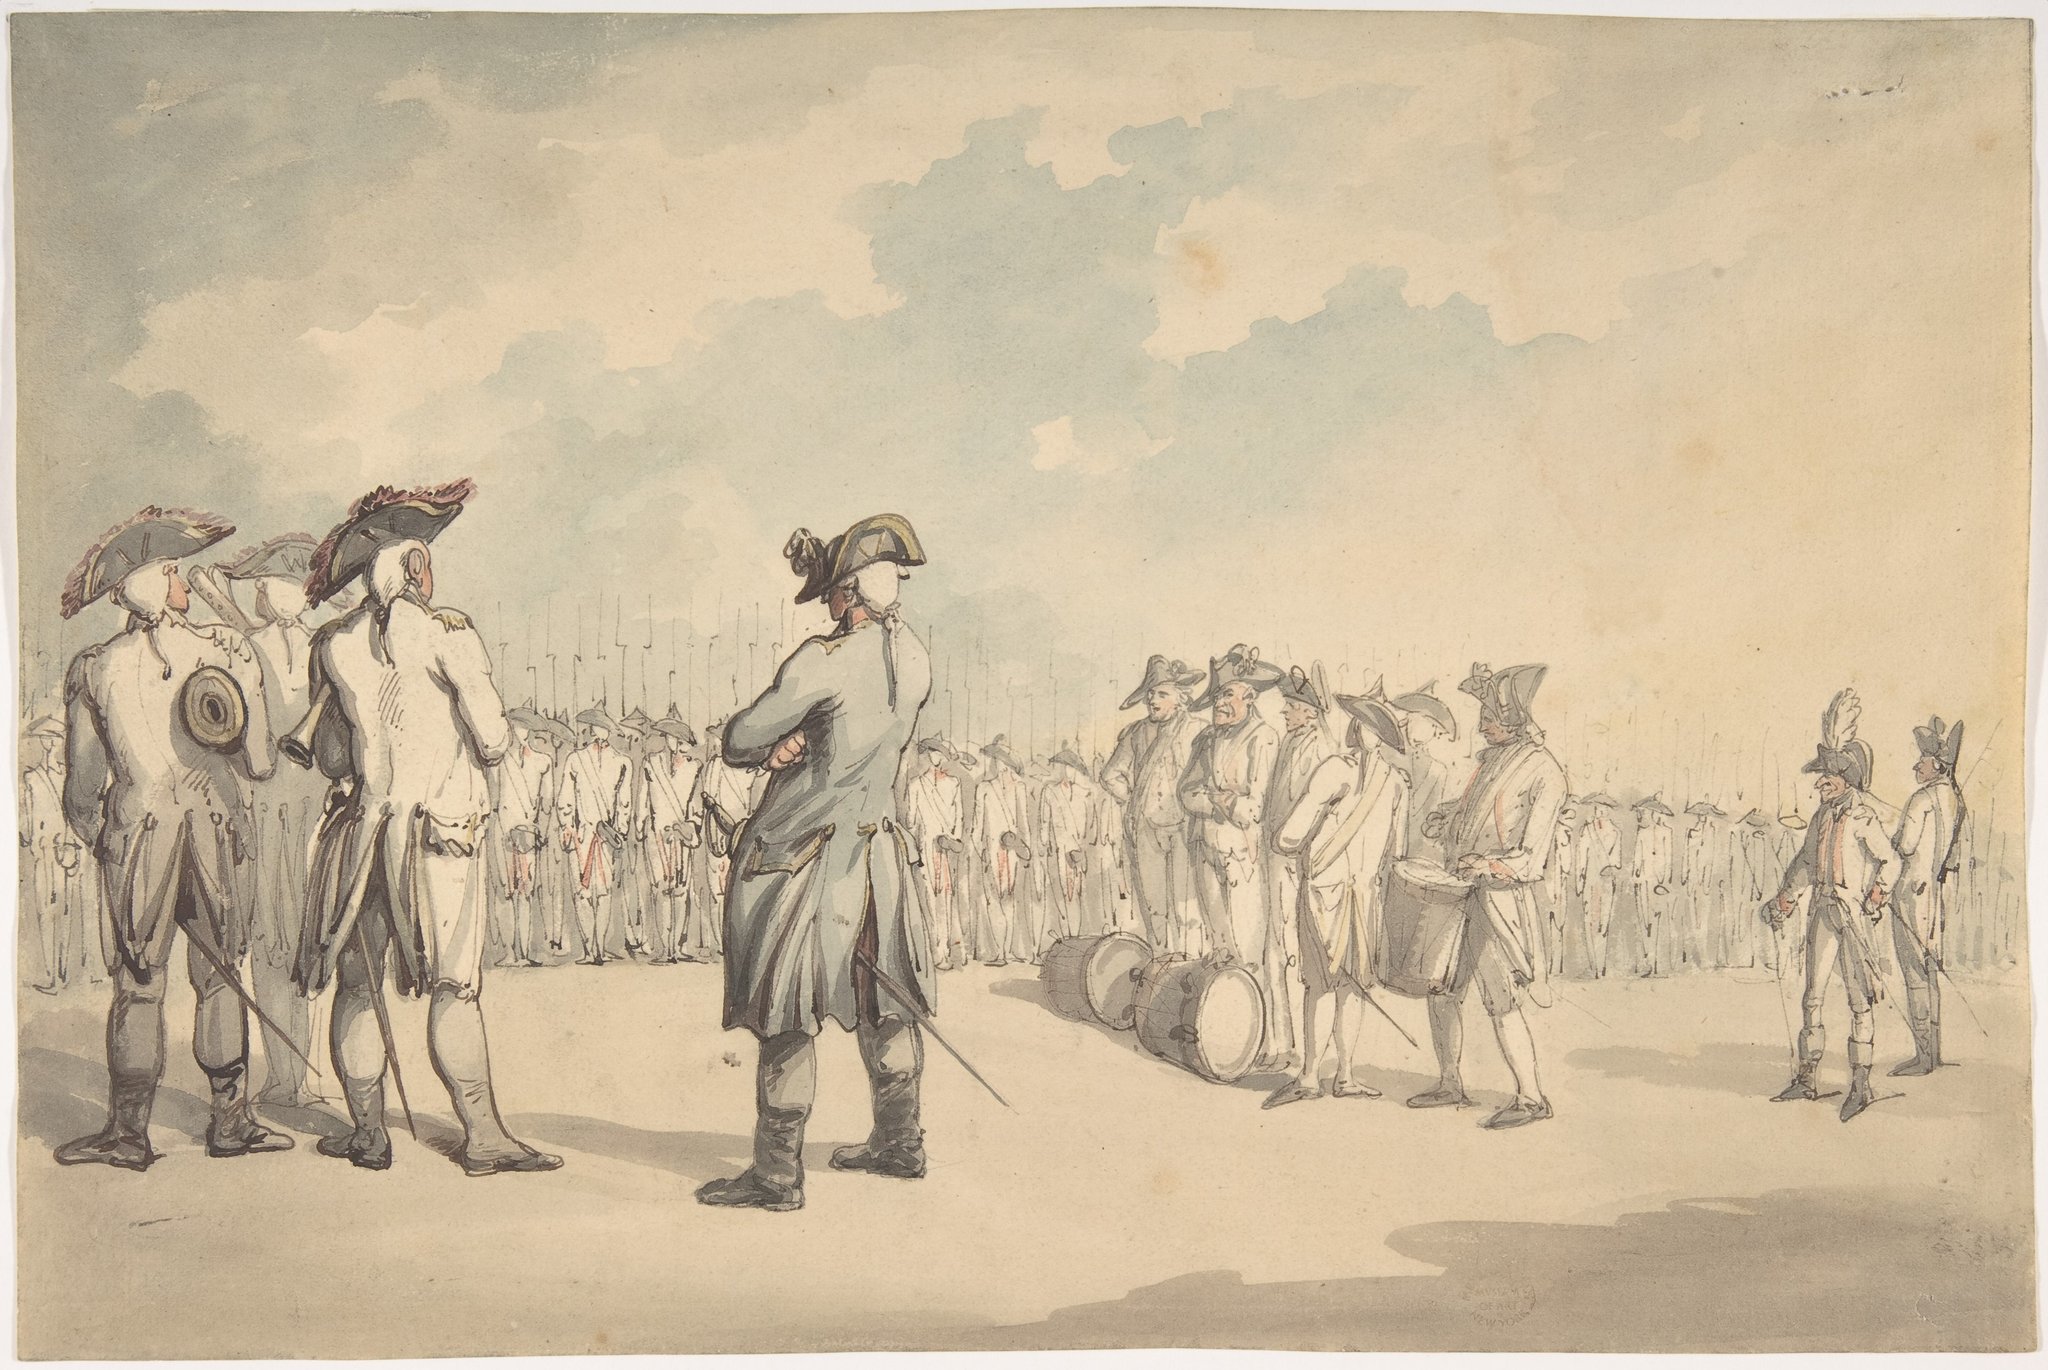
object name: drawing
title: The Review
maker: thomas rowlandson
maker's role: artist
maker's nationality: british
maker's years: 1757-1827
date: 1800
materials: ink, watercolor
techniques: brush, pen, wash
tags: soldiers,men,crowd